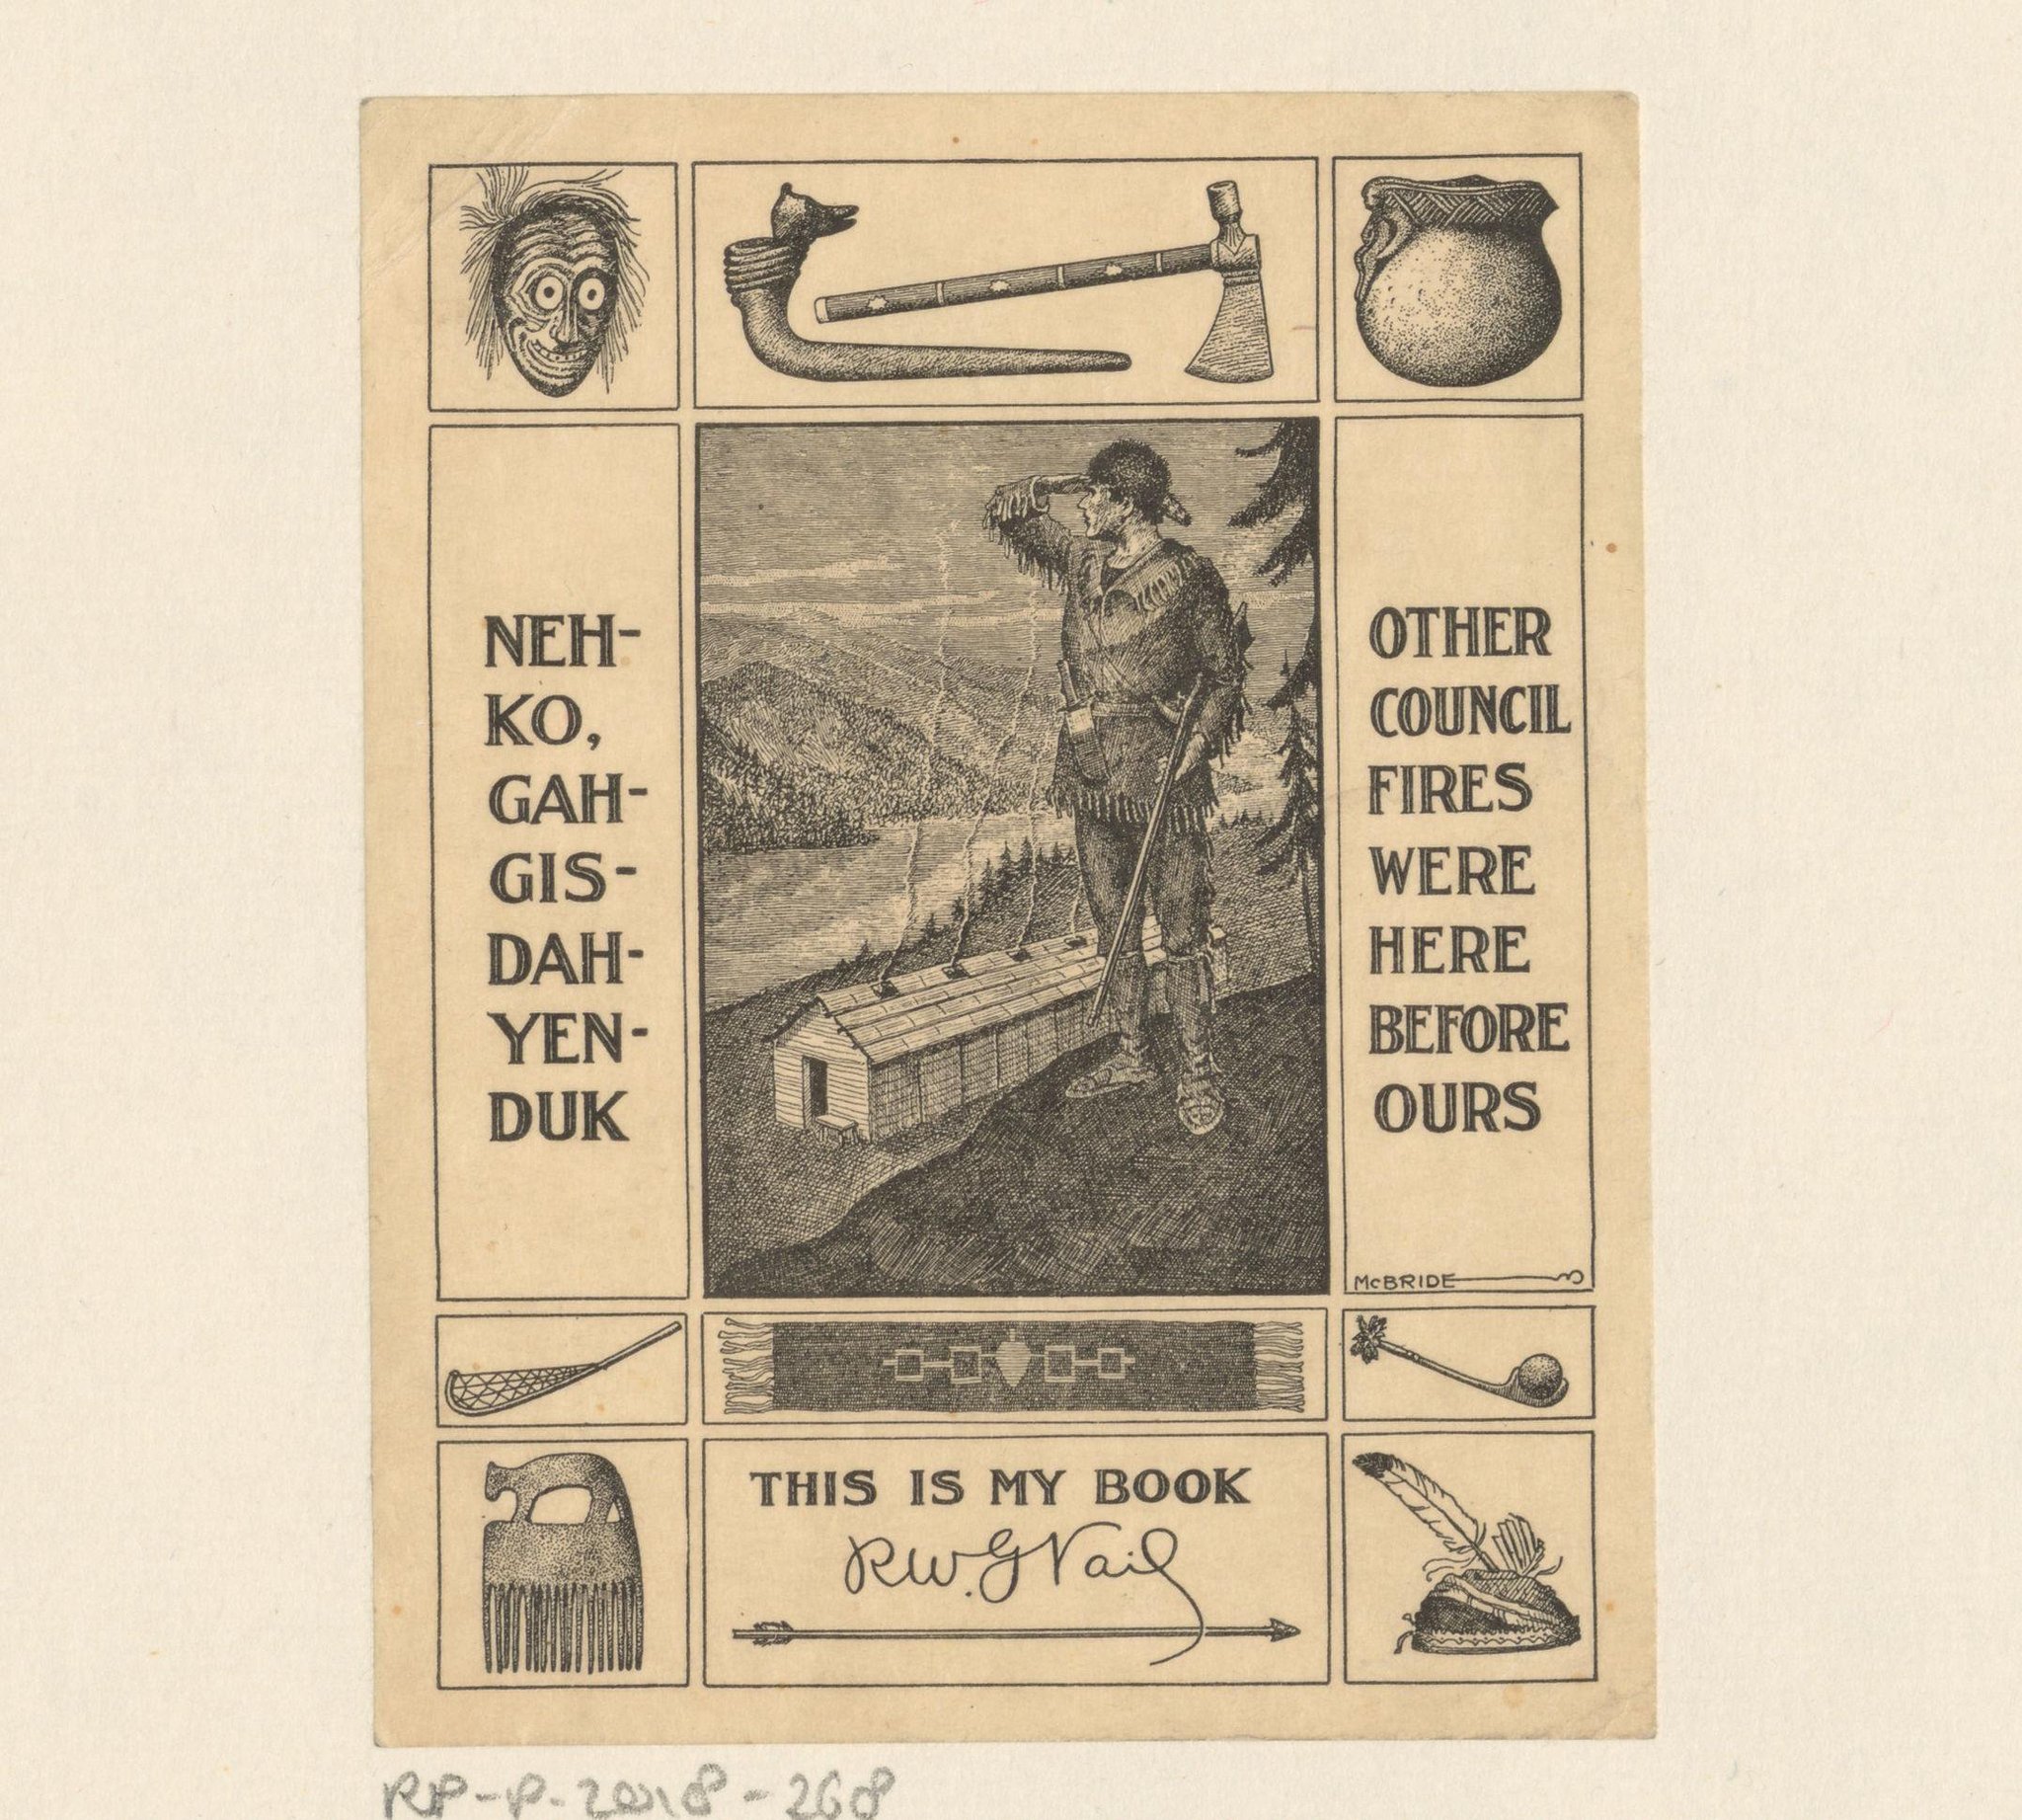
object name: bookplate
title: Other council fires were here before ours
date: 1900-1966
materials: paper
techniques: printing block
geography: north and central america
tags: standing figure, landscapes with waters, waterscapes, seascapes (in the temperate zone), indigenous peoples of north america